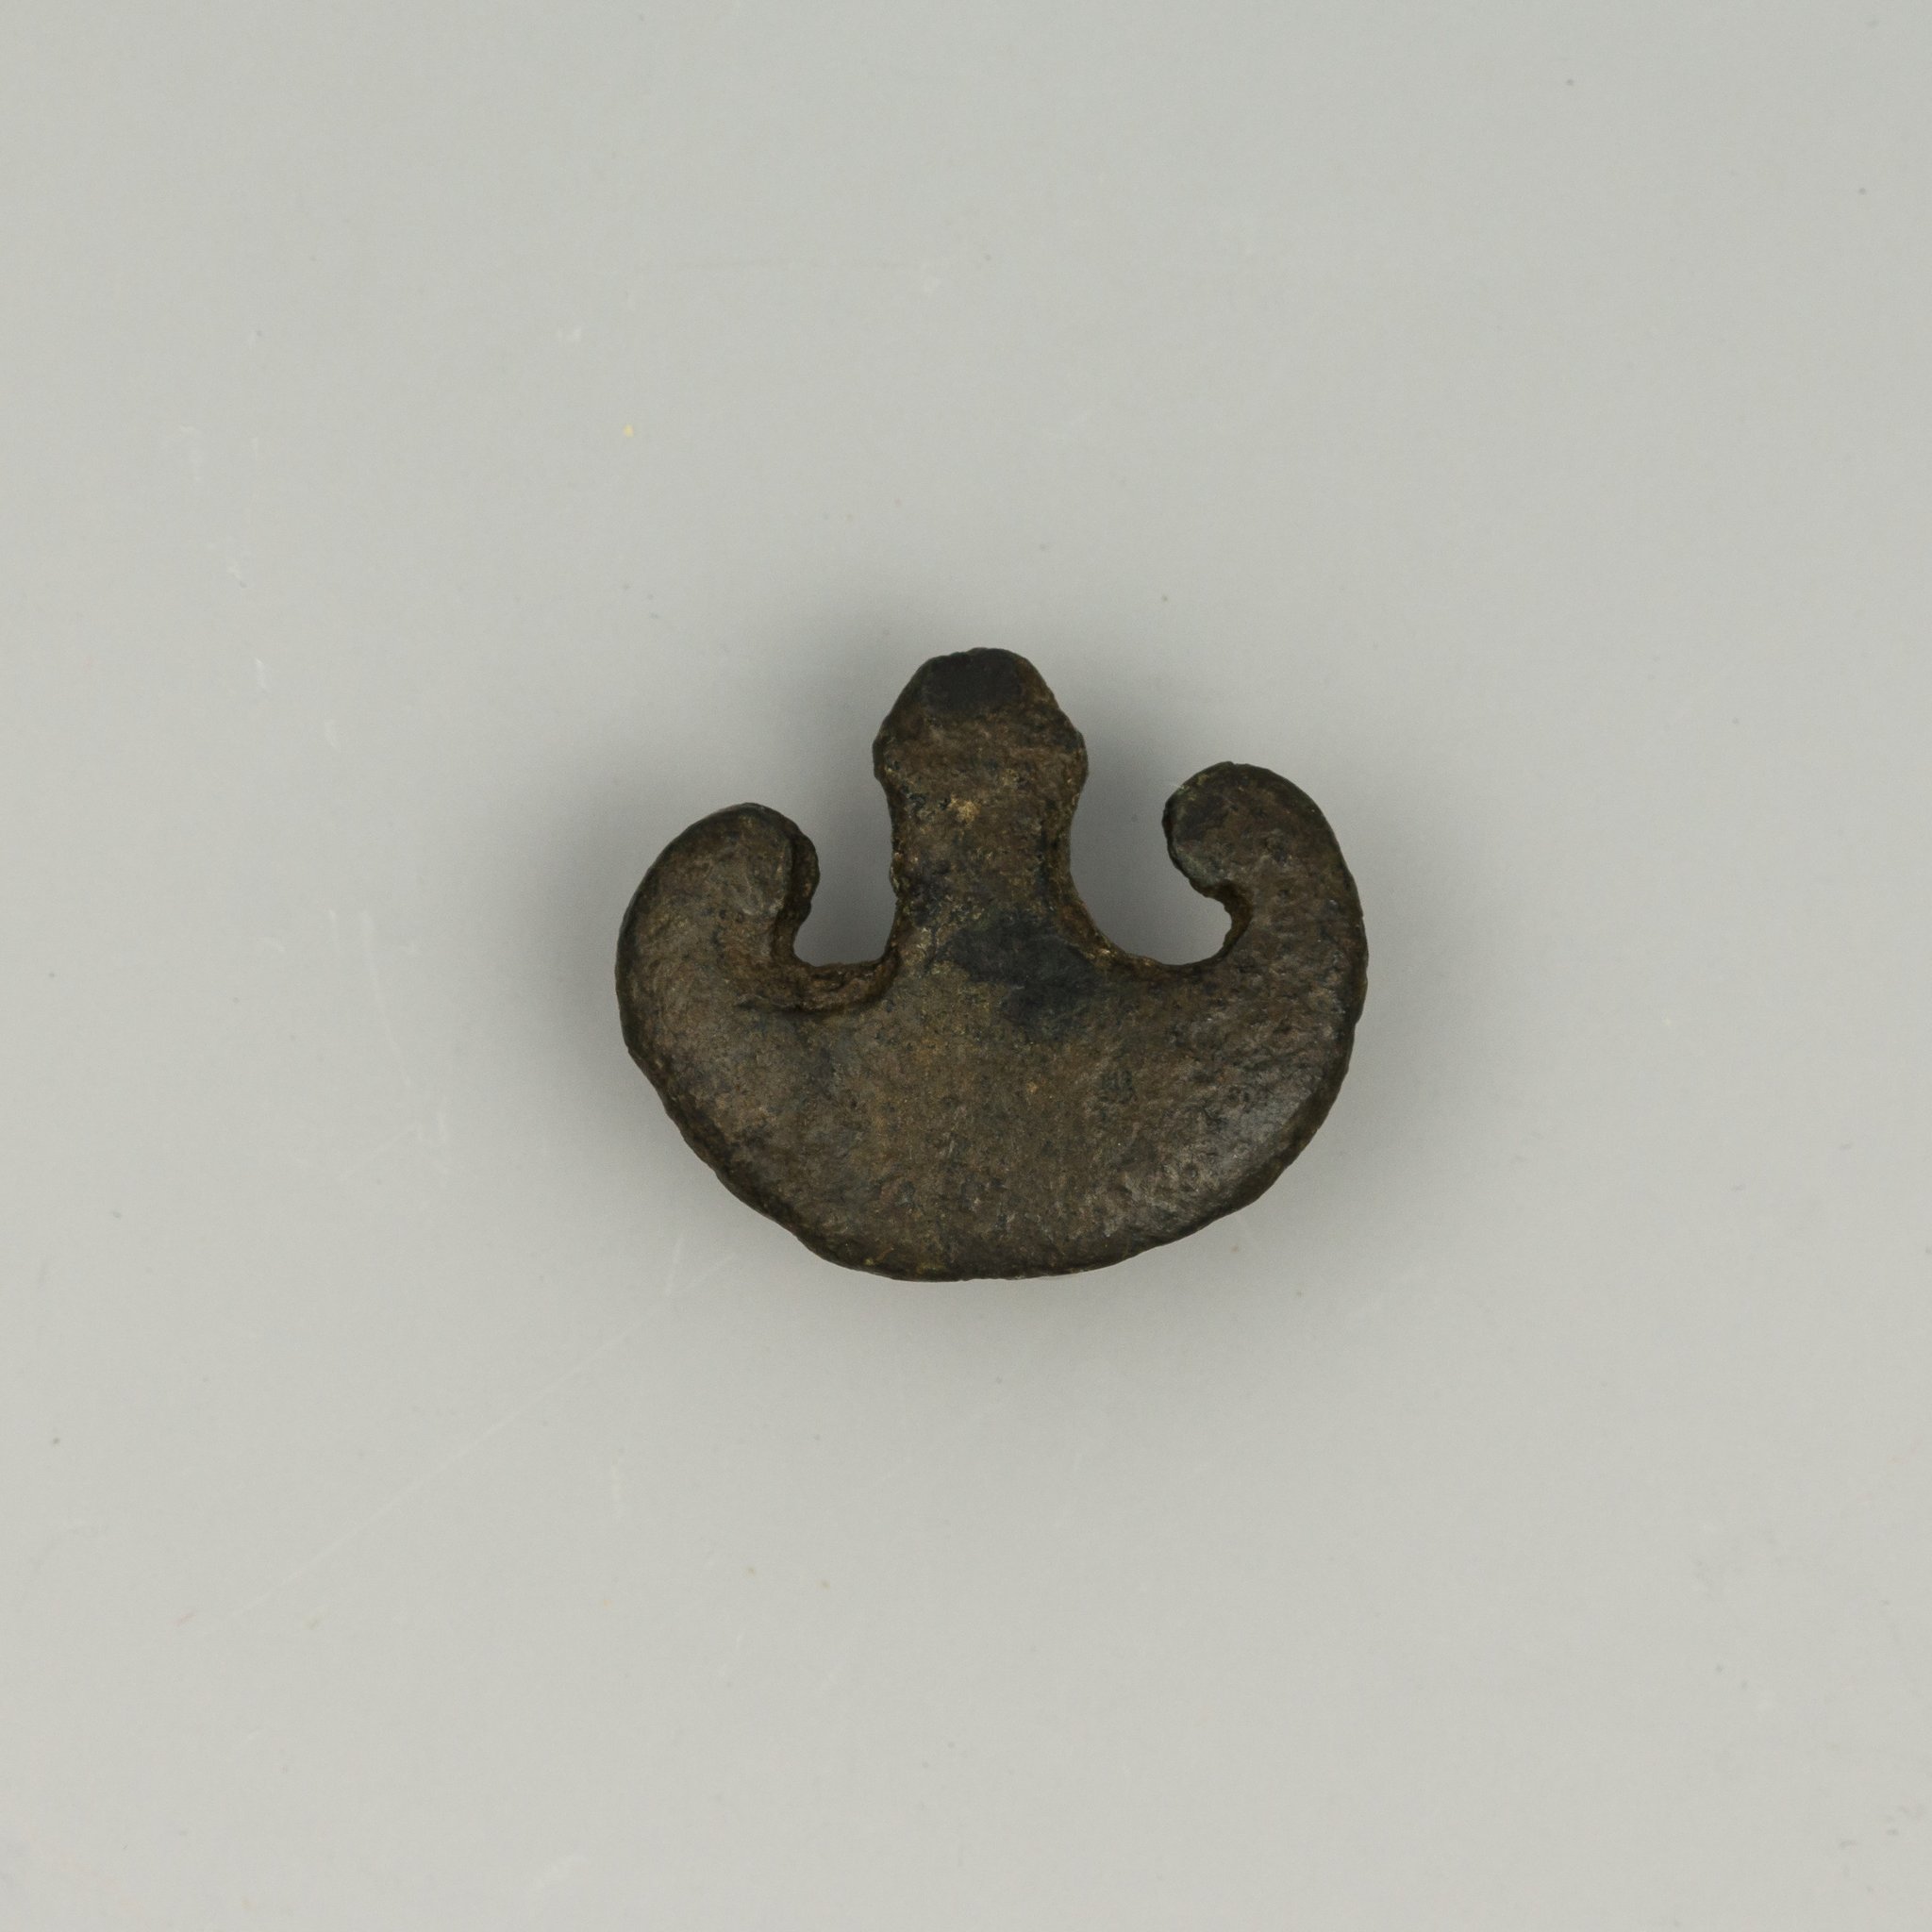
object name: horse tack ornament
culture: roman-german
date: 101-300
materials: copper alloy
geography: germany